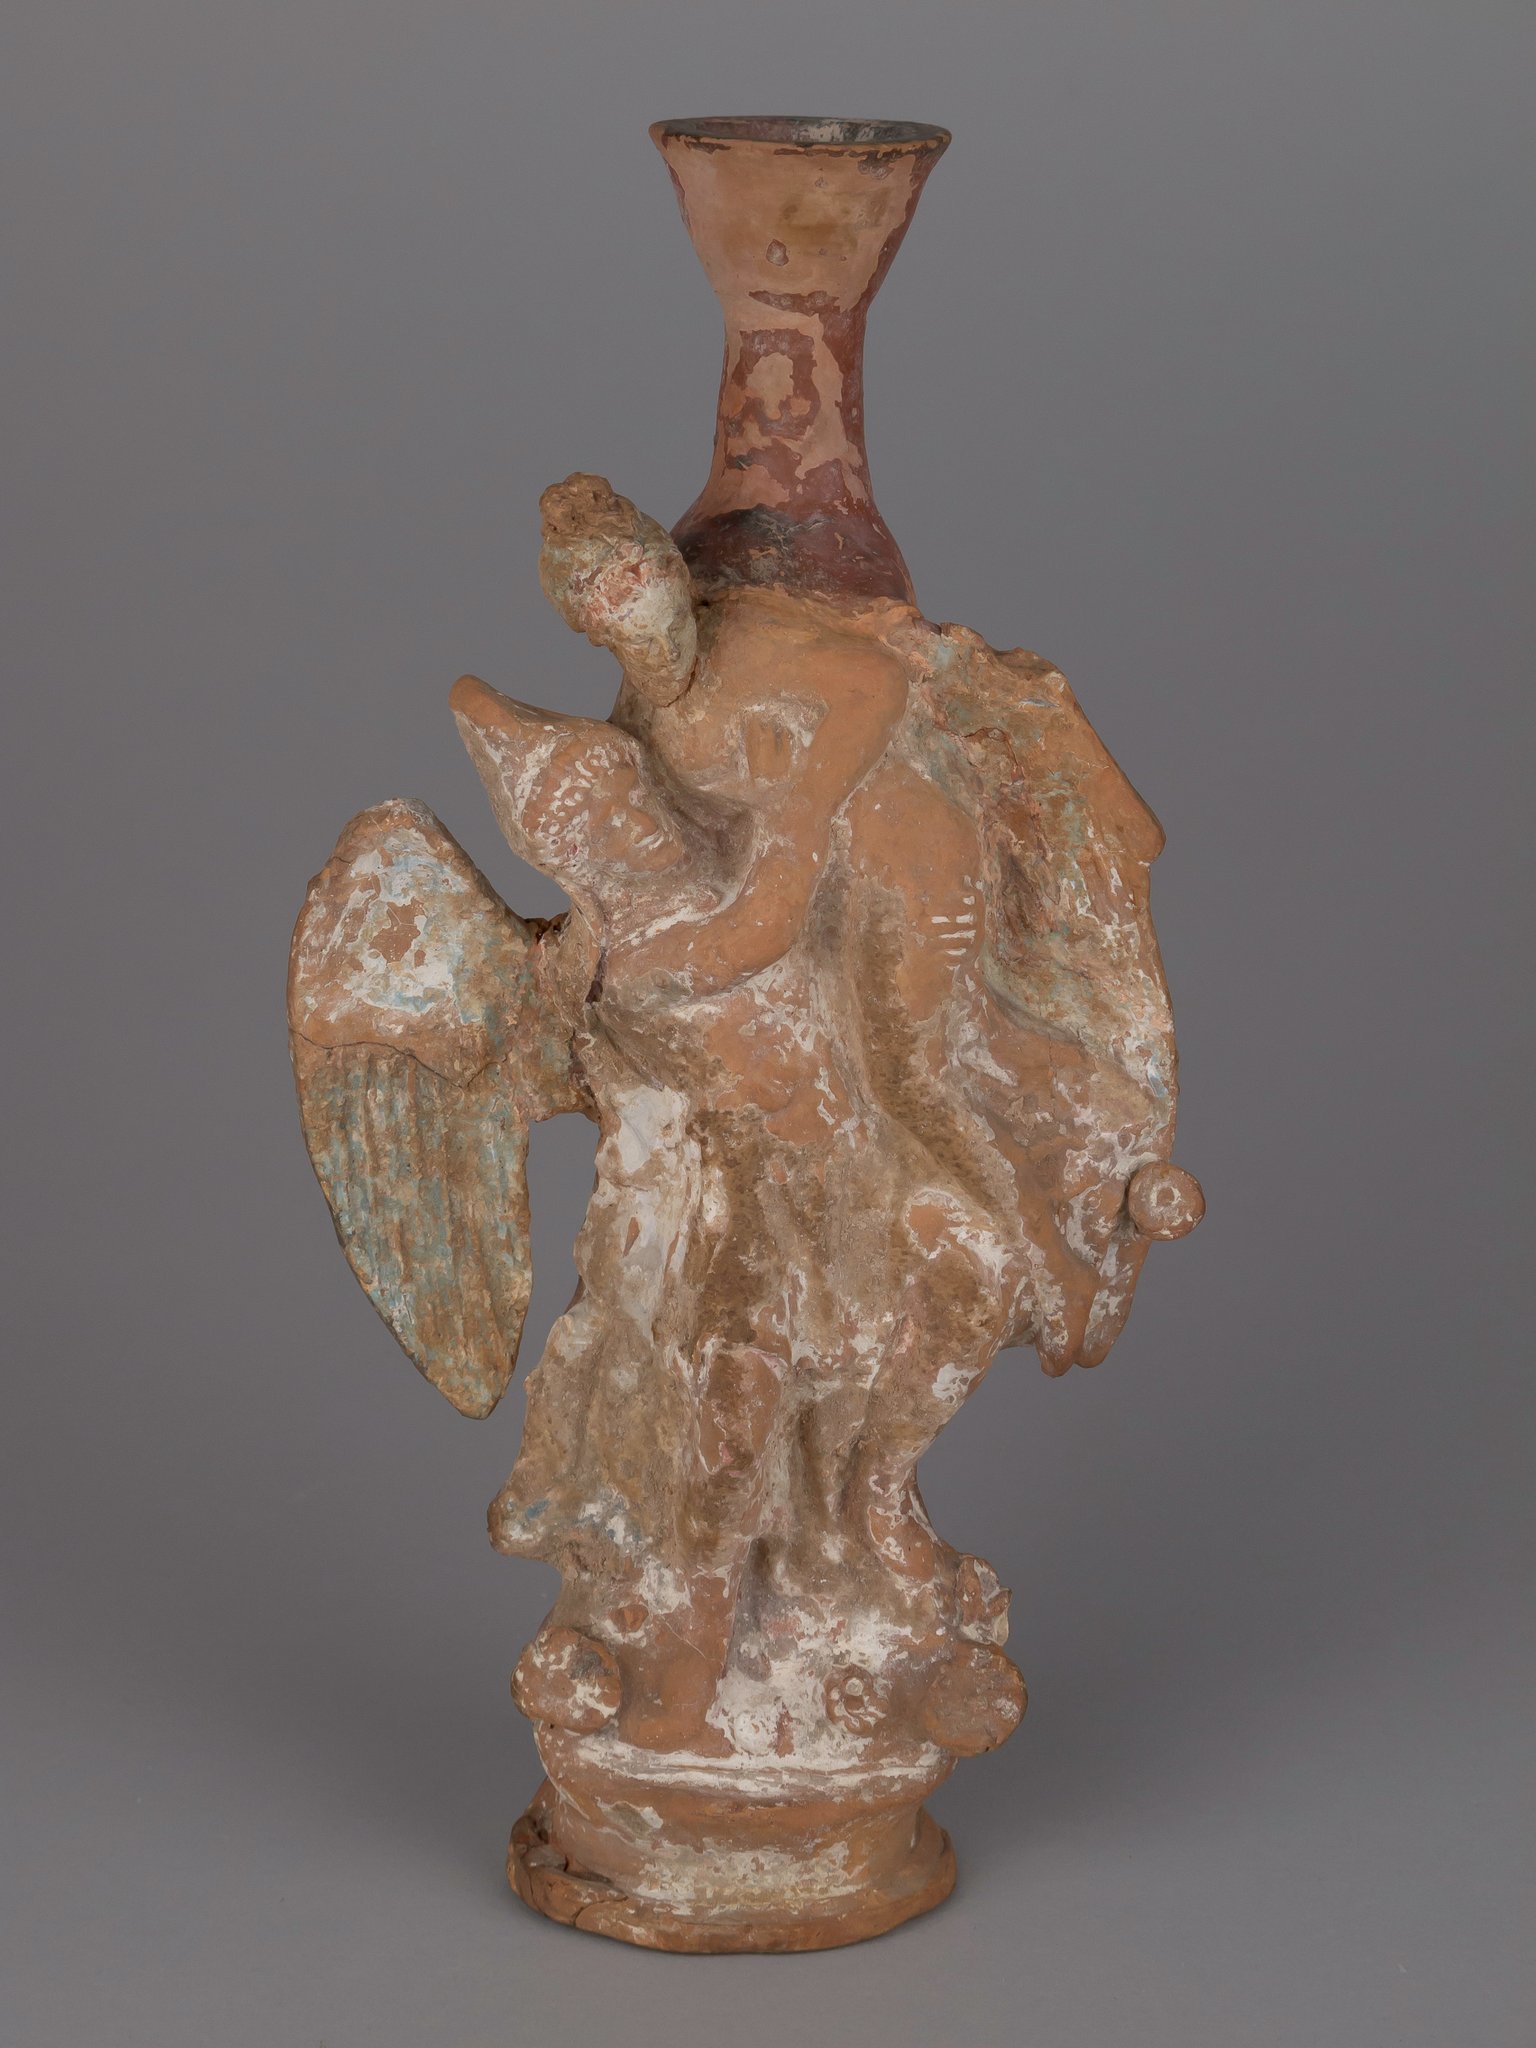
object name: lekythos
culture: greek, attic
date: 400-301 BCE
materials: terracotta